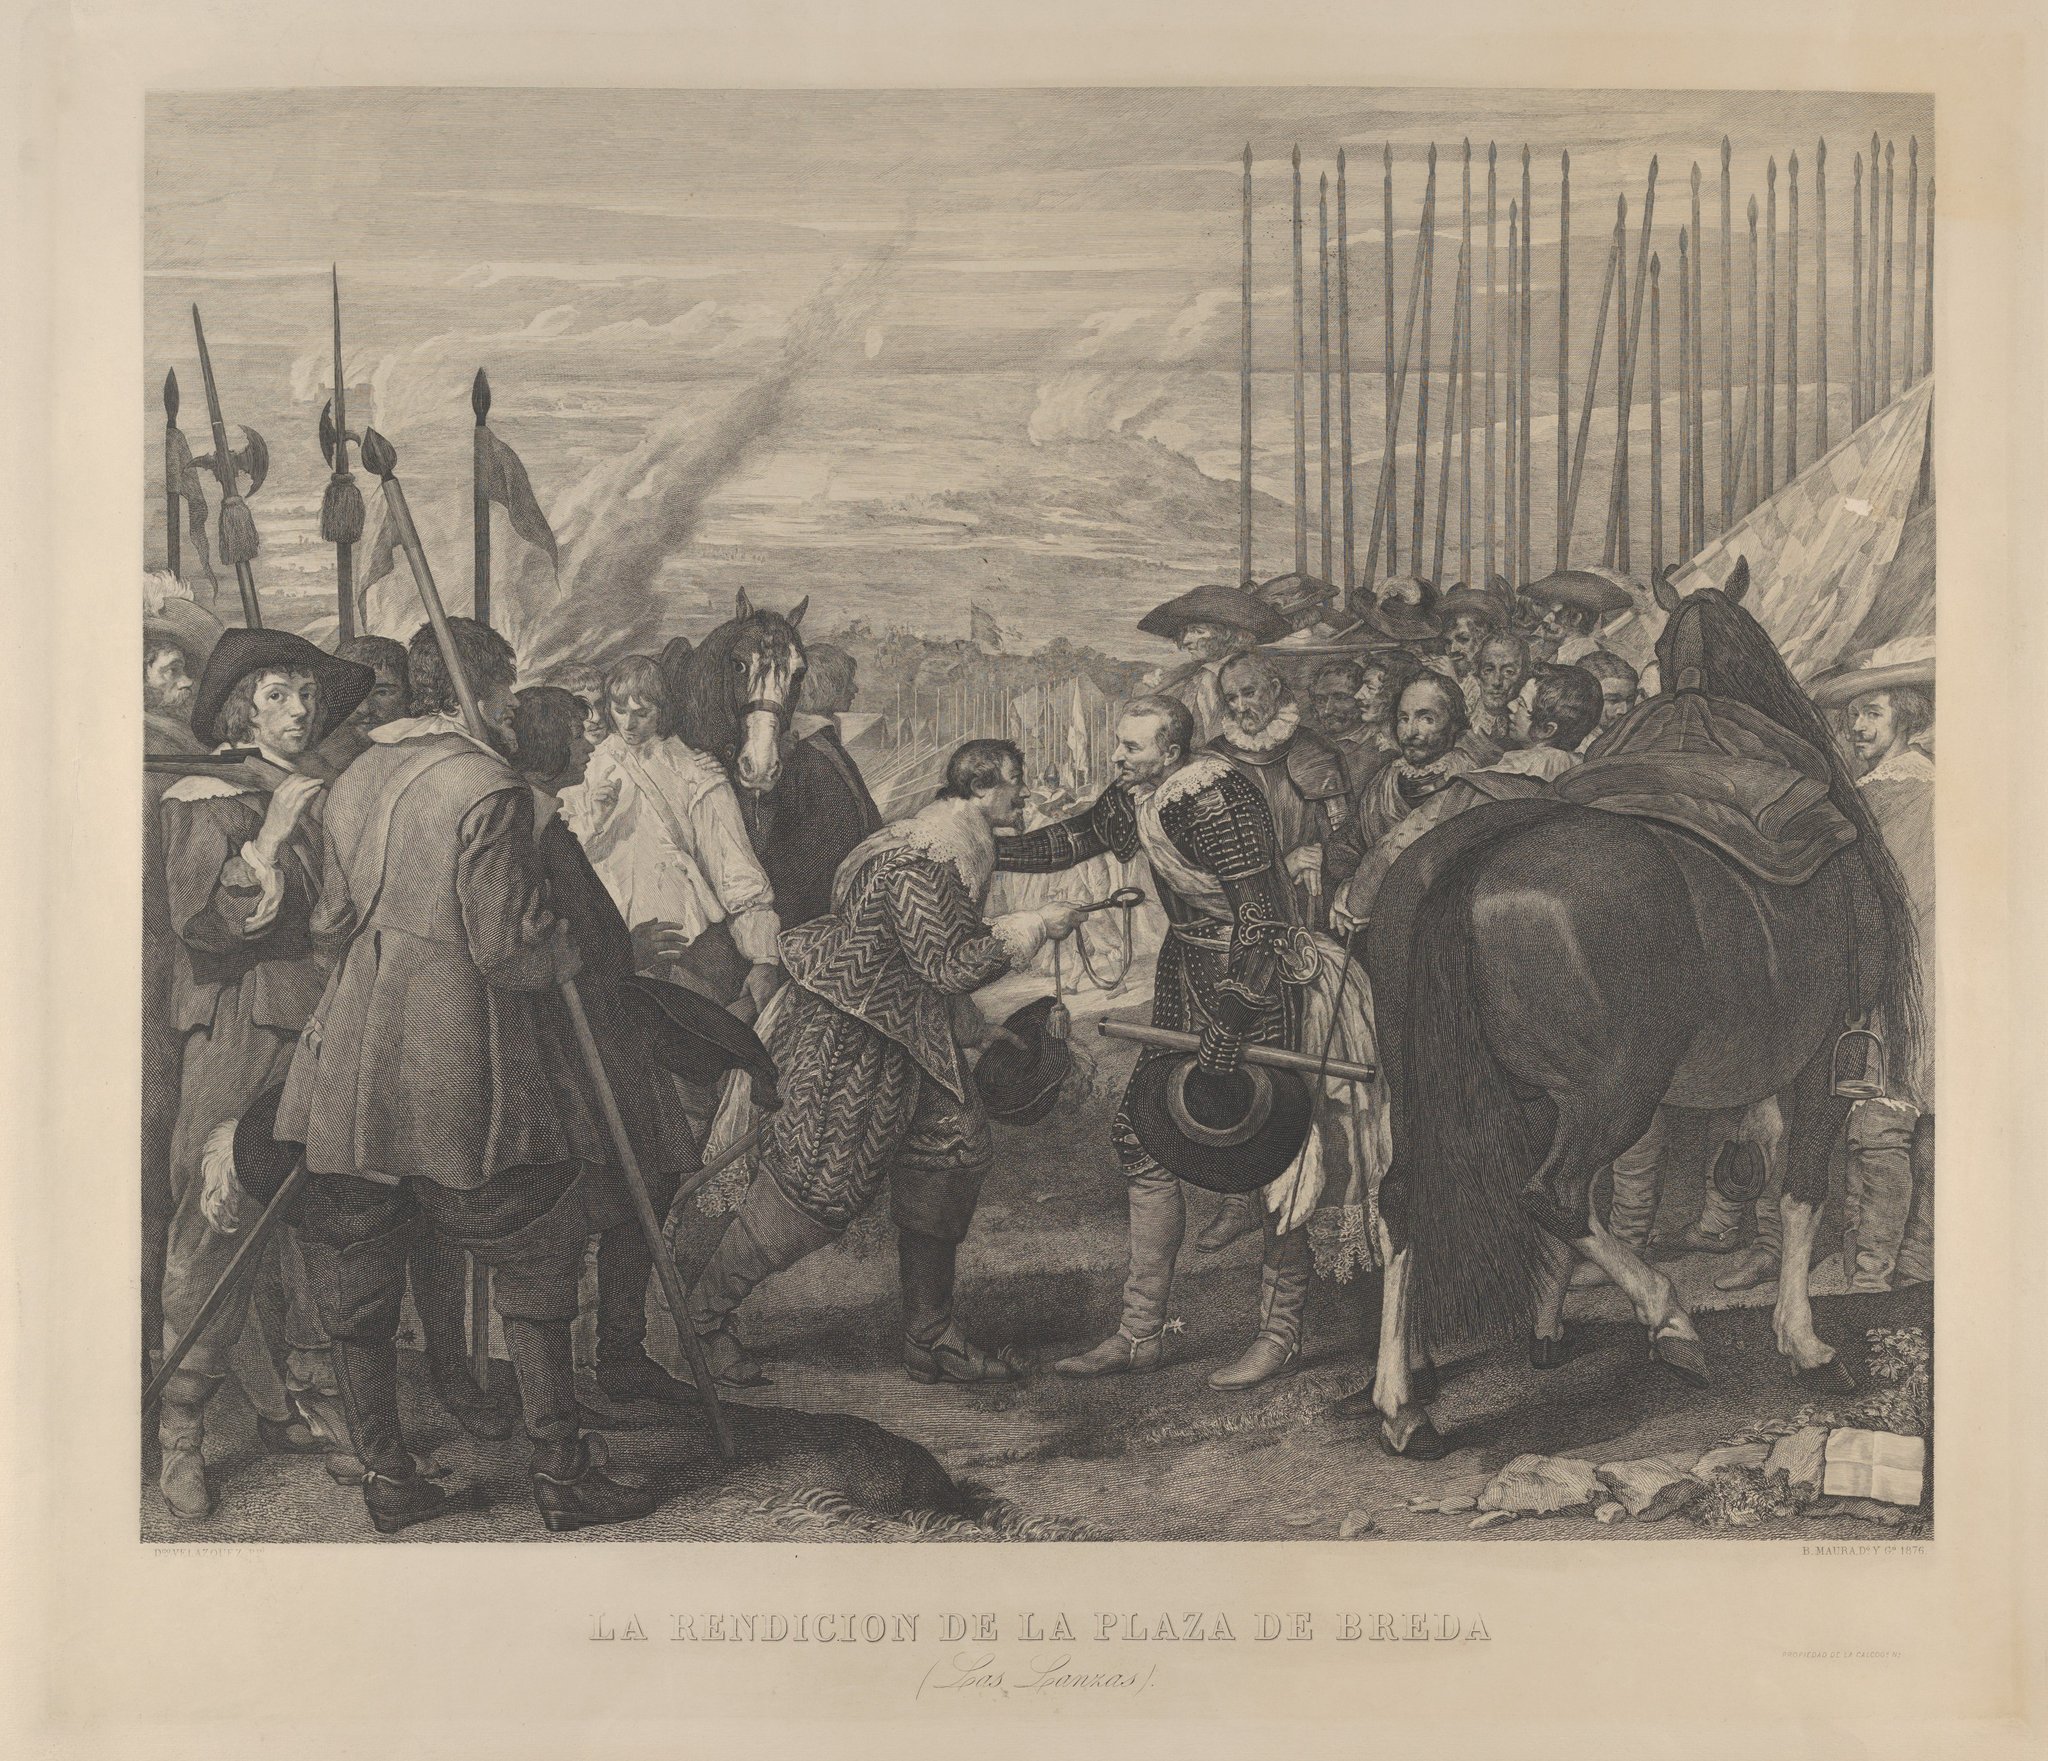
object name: print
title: The Surrender at Breda or 'Las Lanzas' (The Lances), after Velázquez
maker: bartolomé maura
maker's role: artist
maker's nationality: spanish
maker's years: 1599-1660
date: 1876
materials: paper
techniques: etching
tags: soldiers,weapons,men,horses